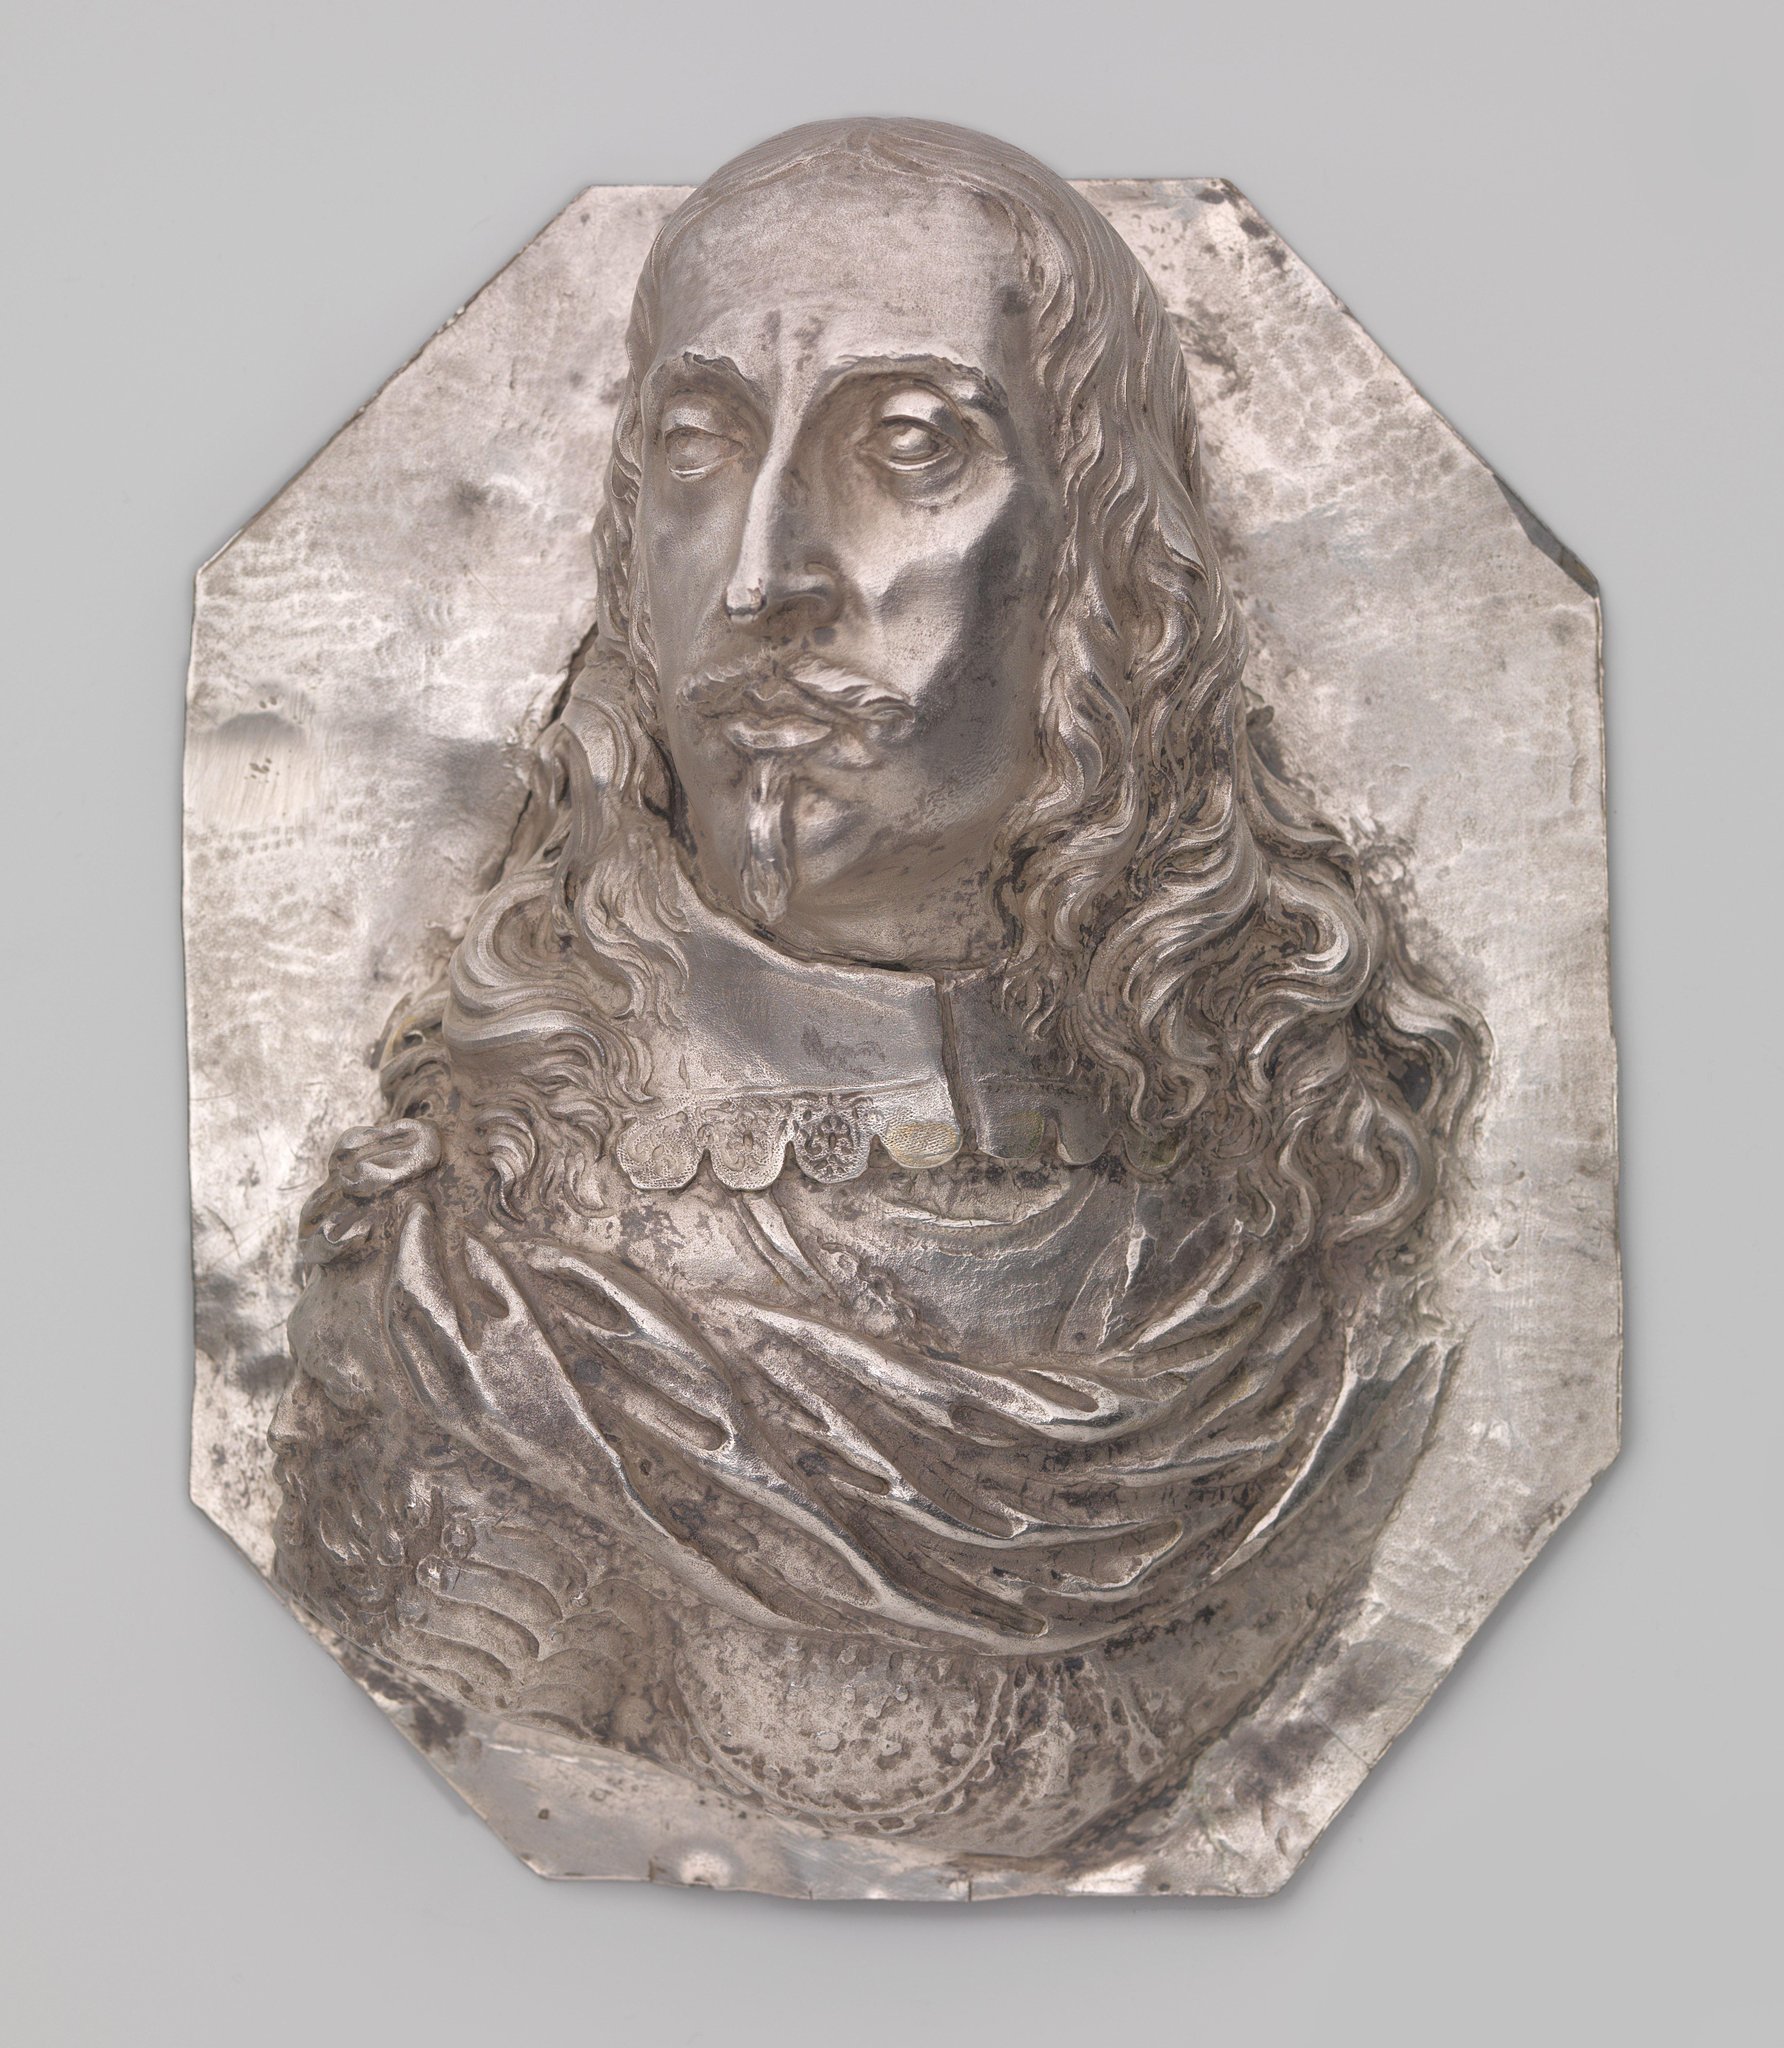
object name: plaque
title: Zilveren plaquette van aartshertog Leopold Wilhelm van Habsburg (1614-1662)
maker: jan van den hoecke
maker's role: painter, print maker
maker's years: 1611-1651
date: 1650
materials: wood, silver, shell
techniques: casting, forging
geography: southern netherlands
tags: vienna, leopold willem van oostenrijk (landvoogd der zuidelijke nederlanden), southern netherlands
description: Op een achthoekige plaat het borstbeeld van aartshertog Leopold Wilhelm van Habsburg, hoogreliëf. Rechterschouder naar voren, lang krullend haar, snor en sik, draagt harnas met afbeelding van een gezicht op de rechterschouder, een geknoopte sjerp van de ene schouder naar de andere. Aan een keten draagt hij het kruis van de Duitse orde (waar Wilhelm von Habsburg sinds 1642 grootmeester van was). Gemerkt; l.o.: J (bijna onleesbaar).